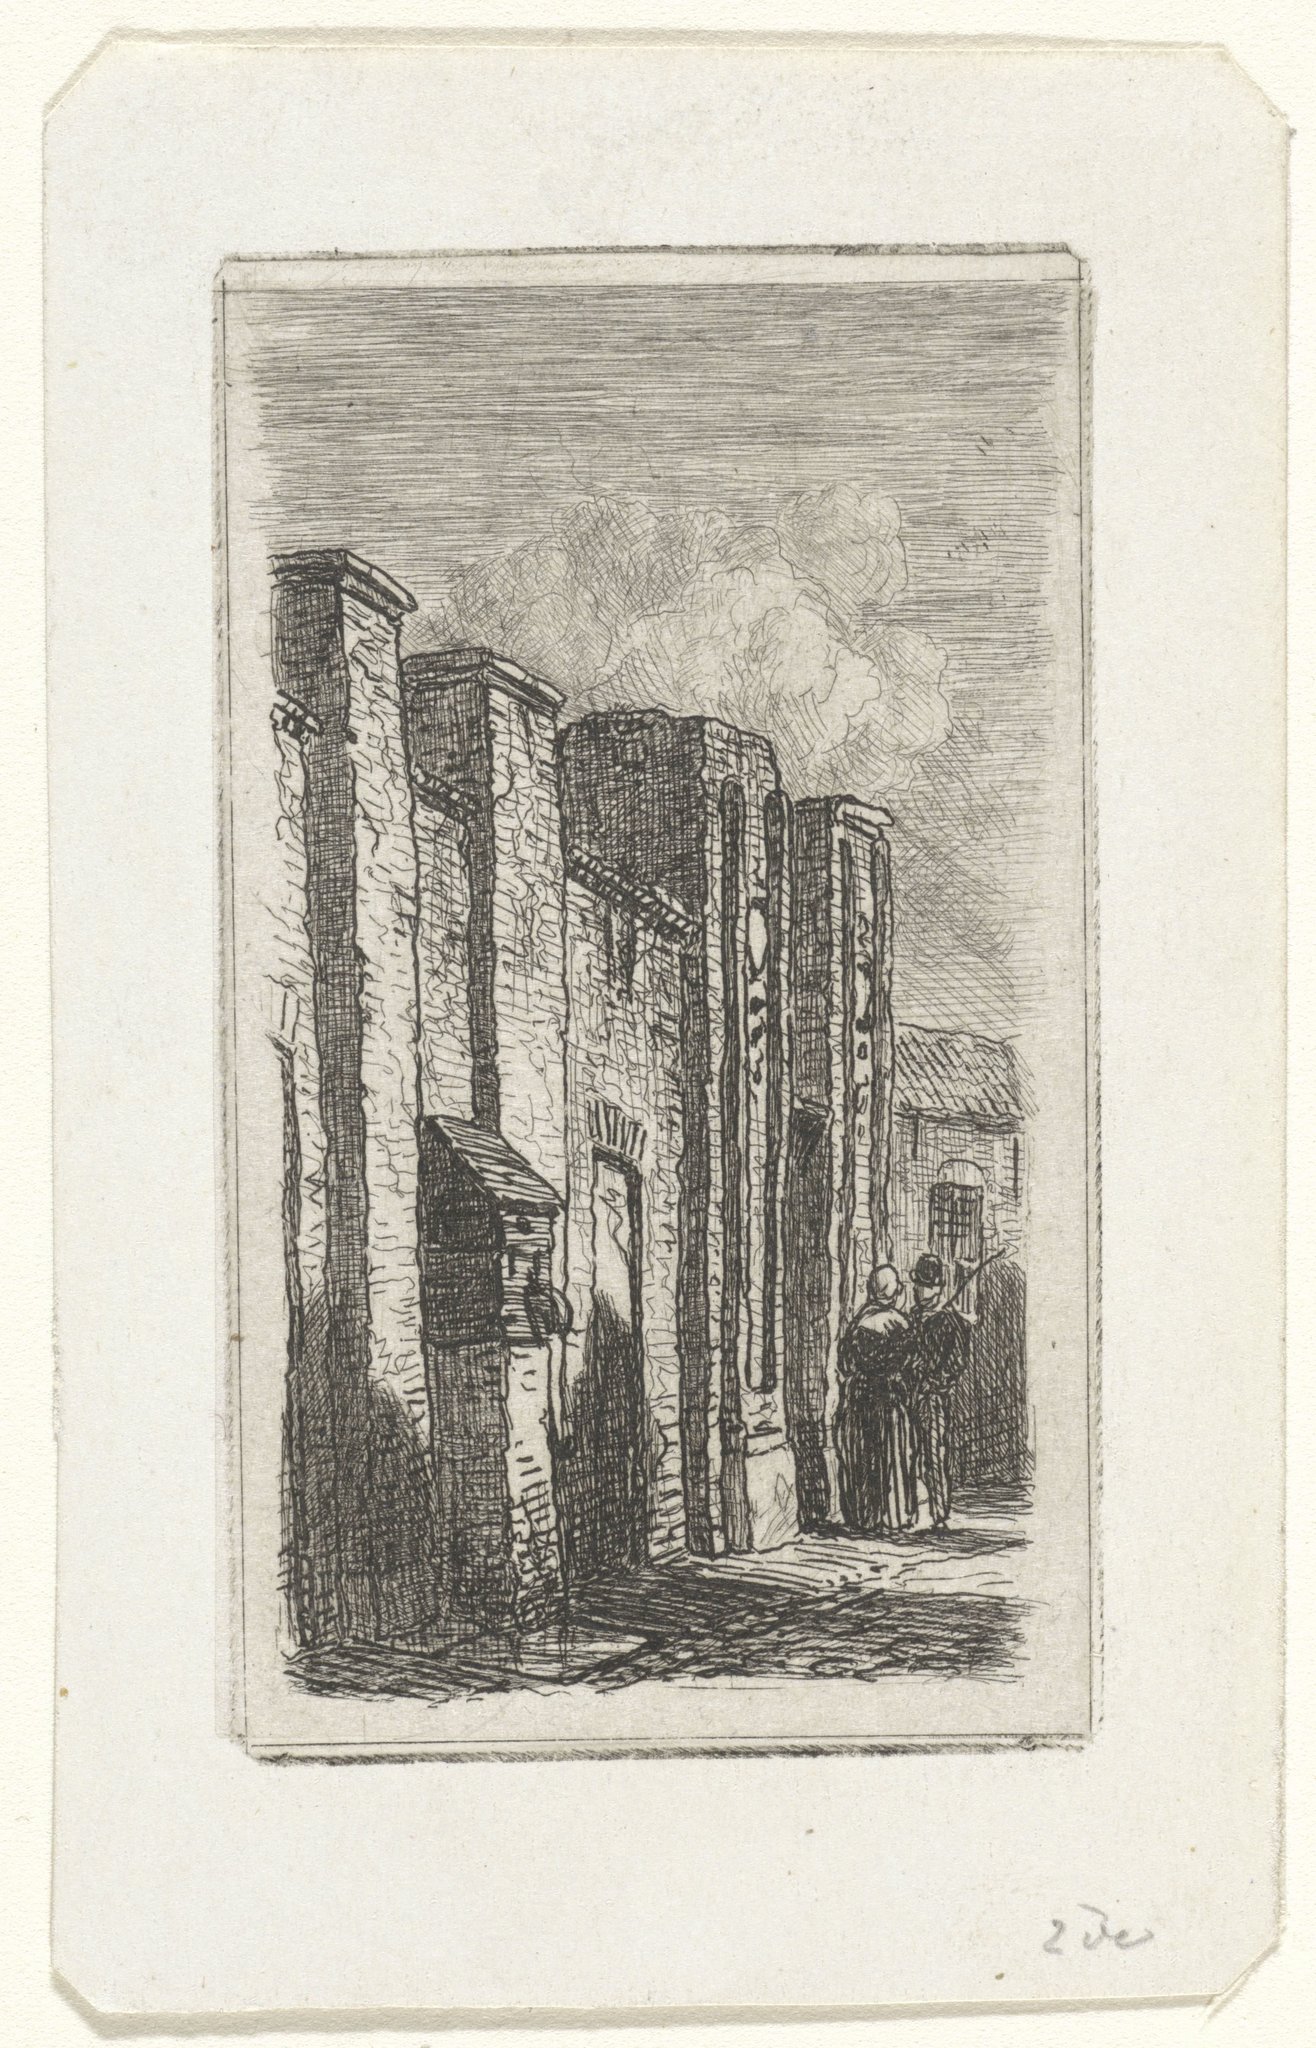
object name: print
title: Muur te Culemborg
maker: jan weissenbruch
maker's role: painter, print maker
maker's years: 1822-1880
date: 1837-1880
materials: paper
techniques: etching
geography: culemborg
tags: fence, wall, paling, city-walls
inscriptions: collector's mark: Lugt 2228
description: Een man en een vrouw staan bij een muur, mogelijk een stadsmuur, met kanteelachtige details en een houten kastje.